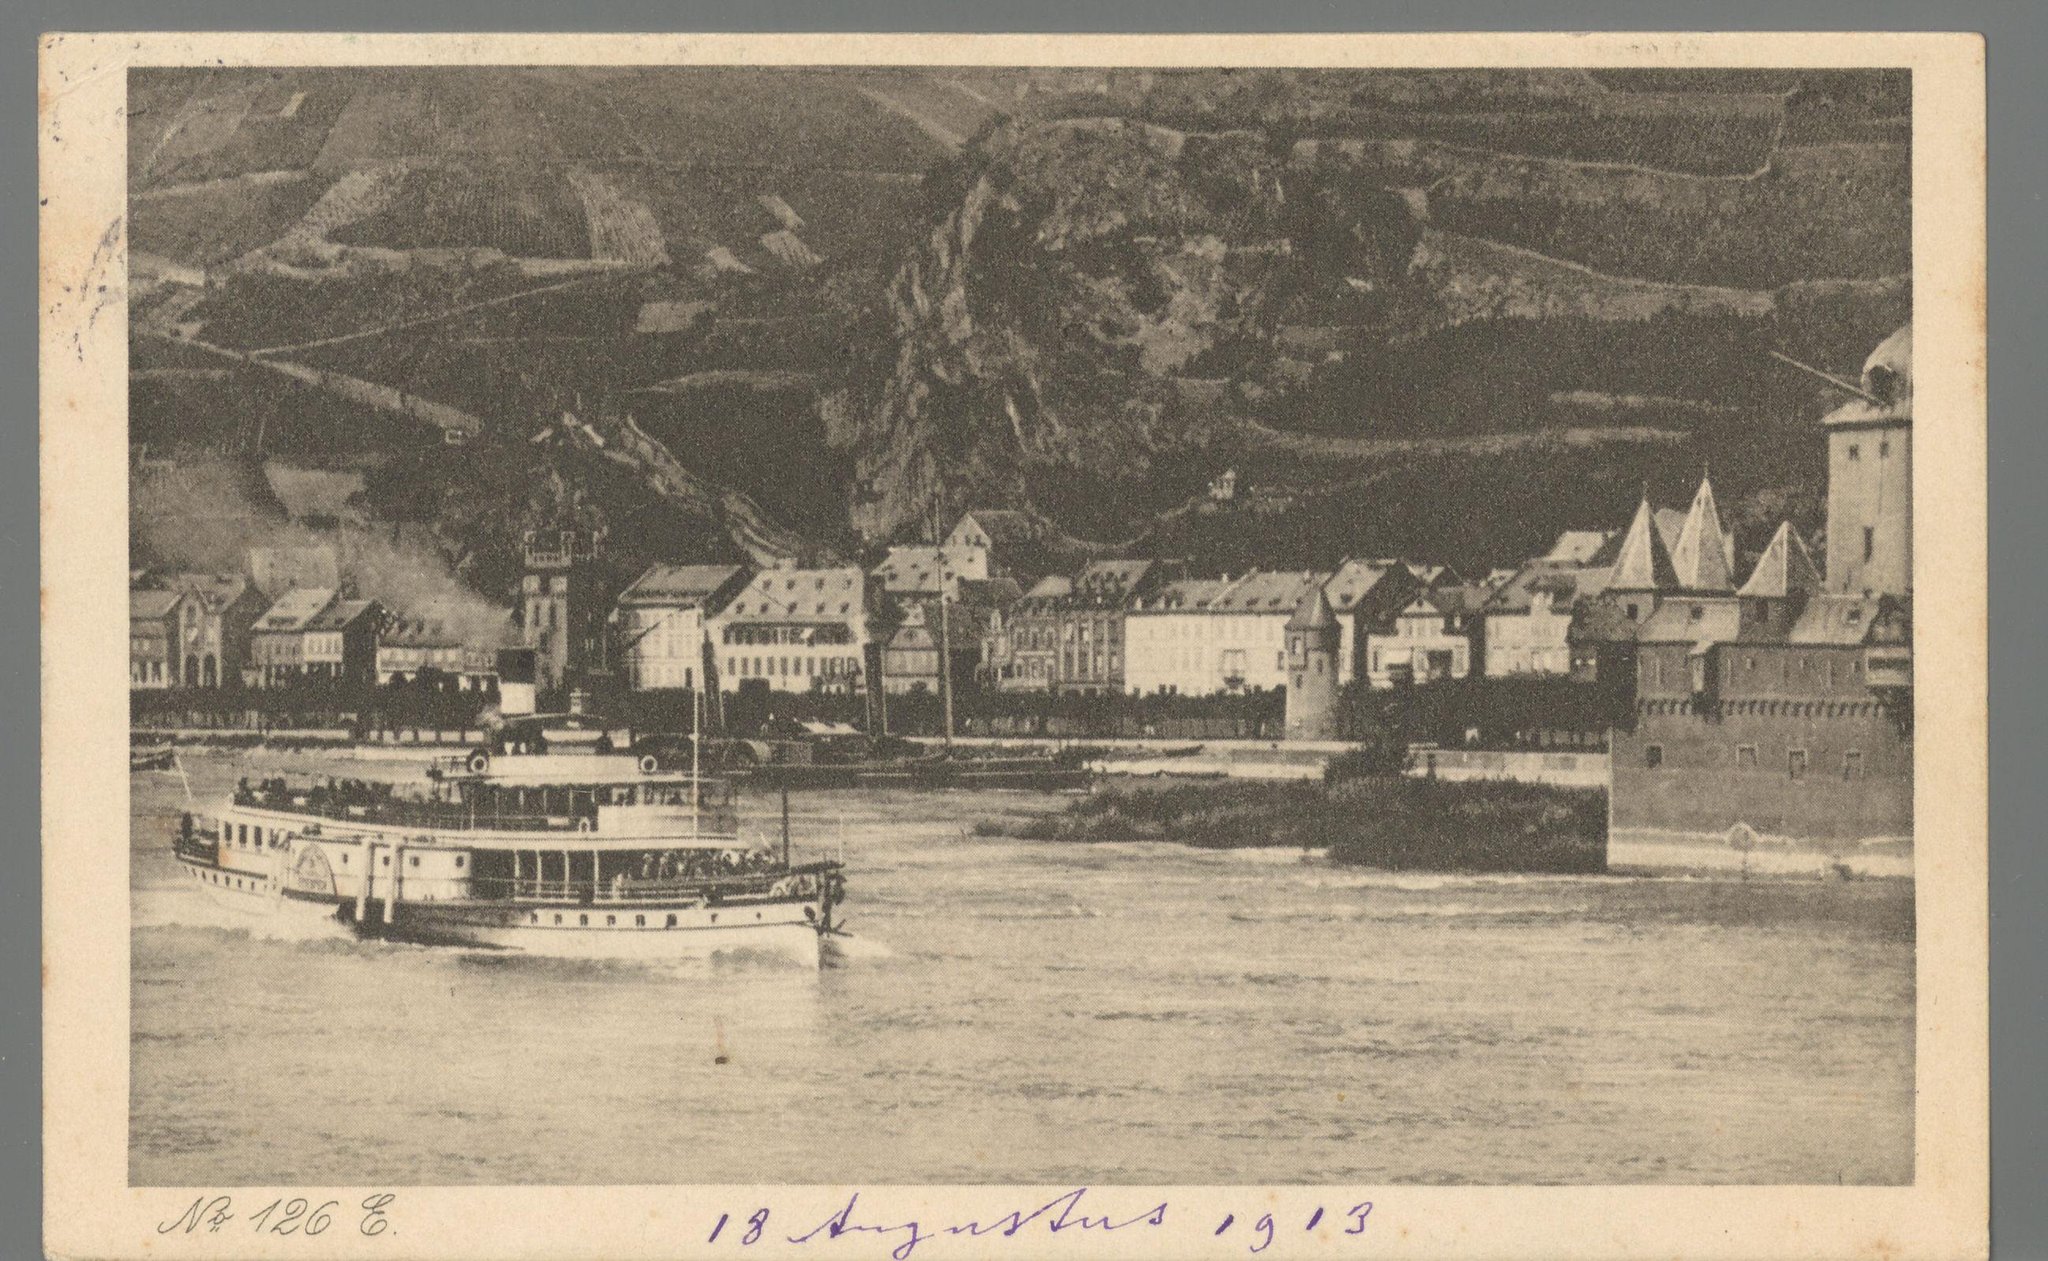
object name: ansichtkaart, prentbriefkaart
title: Kölh-Düsseldorfer Rheindampfschiffahrt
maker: Anonymous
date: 1905-1913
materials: cardboard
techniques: rotogravure, writing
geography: rhine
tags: city-view, and landscape with man-made constructions, river, steamship, motorship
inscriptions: postage stamp